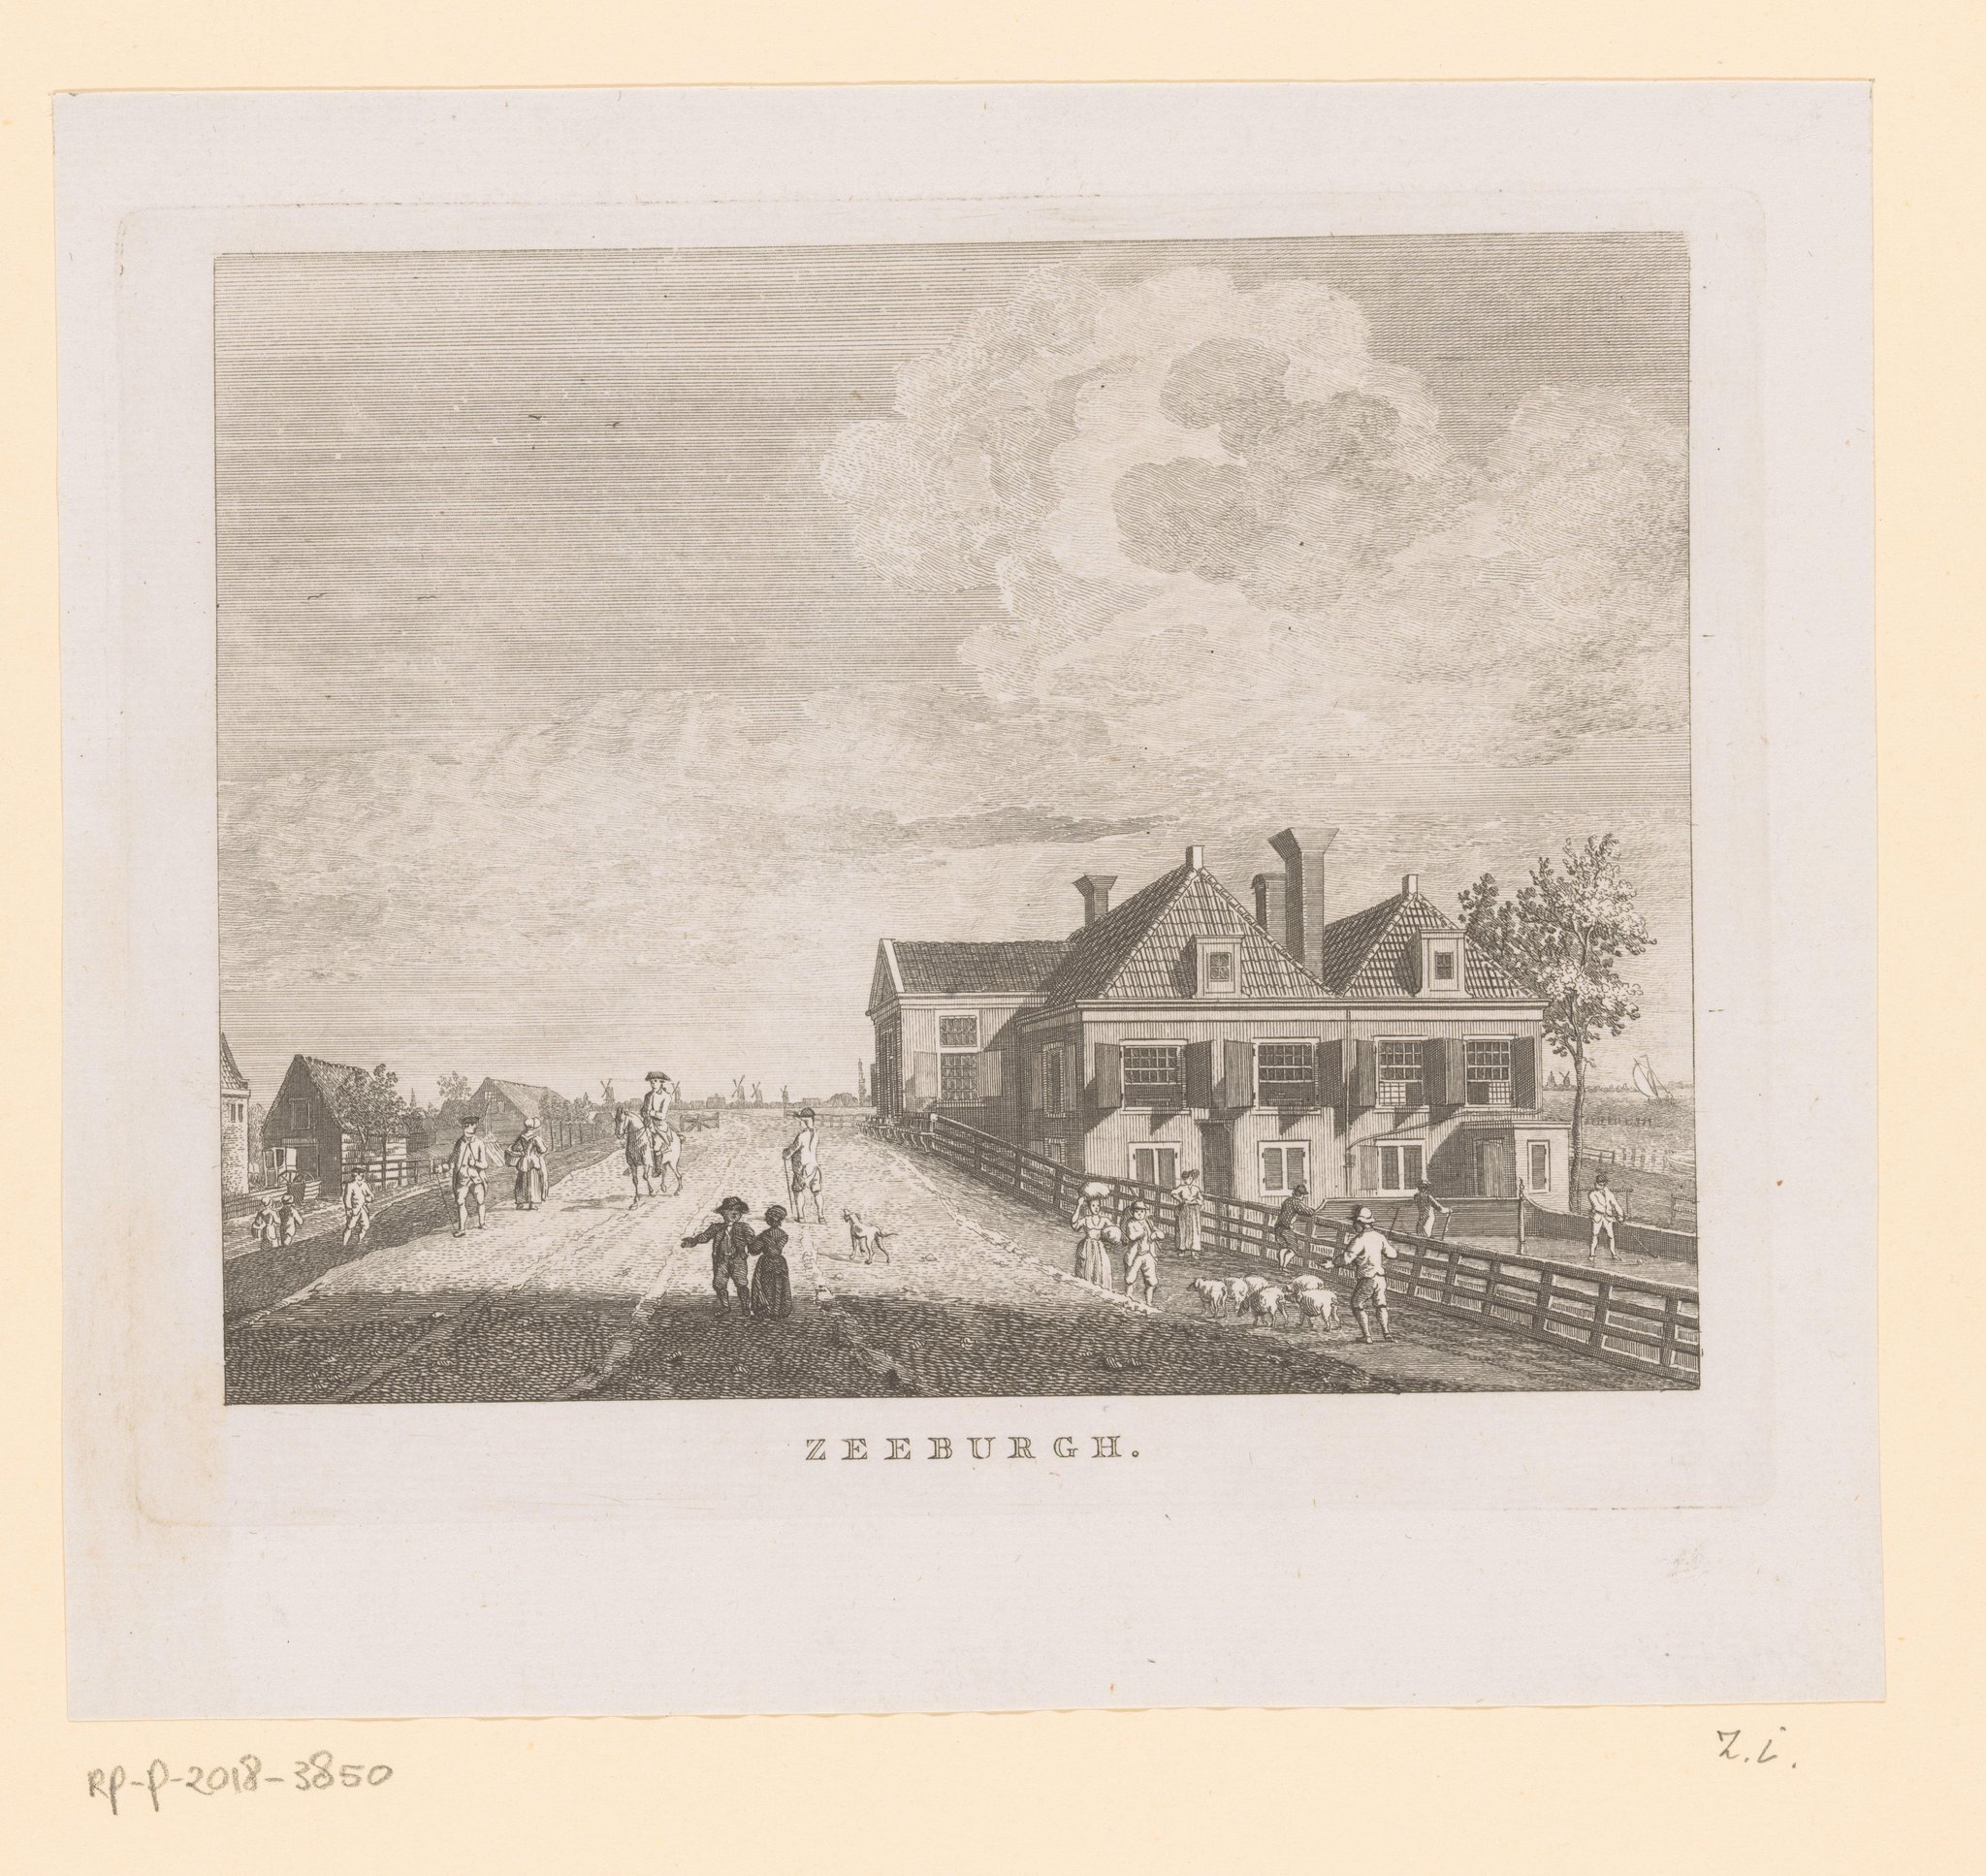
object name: print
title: Zeeburgh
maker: Anonymous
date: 1750-1800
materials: paper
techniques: etching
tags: hotel, hostelry, inn, city-view, and landscape with man-made constructions (+ city(-scape) with figures, staffage), river bank (+ landscape with figures, staffage)